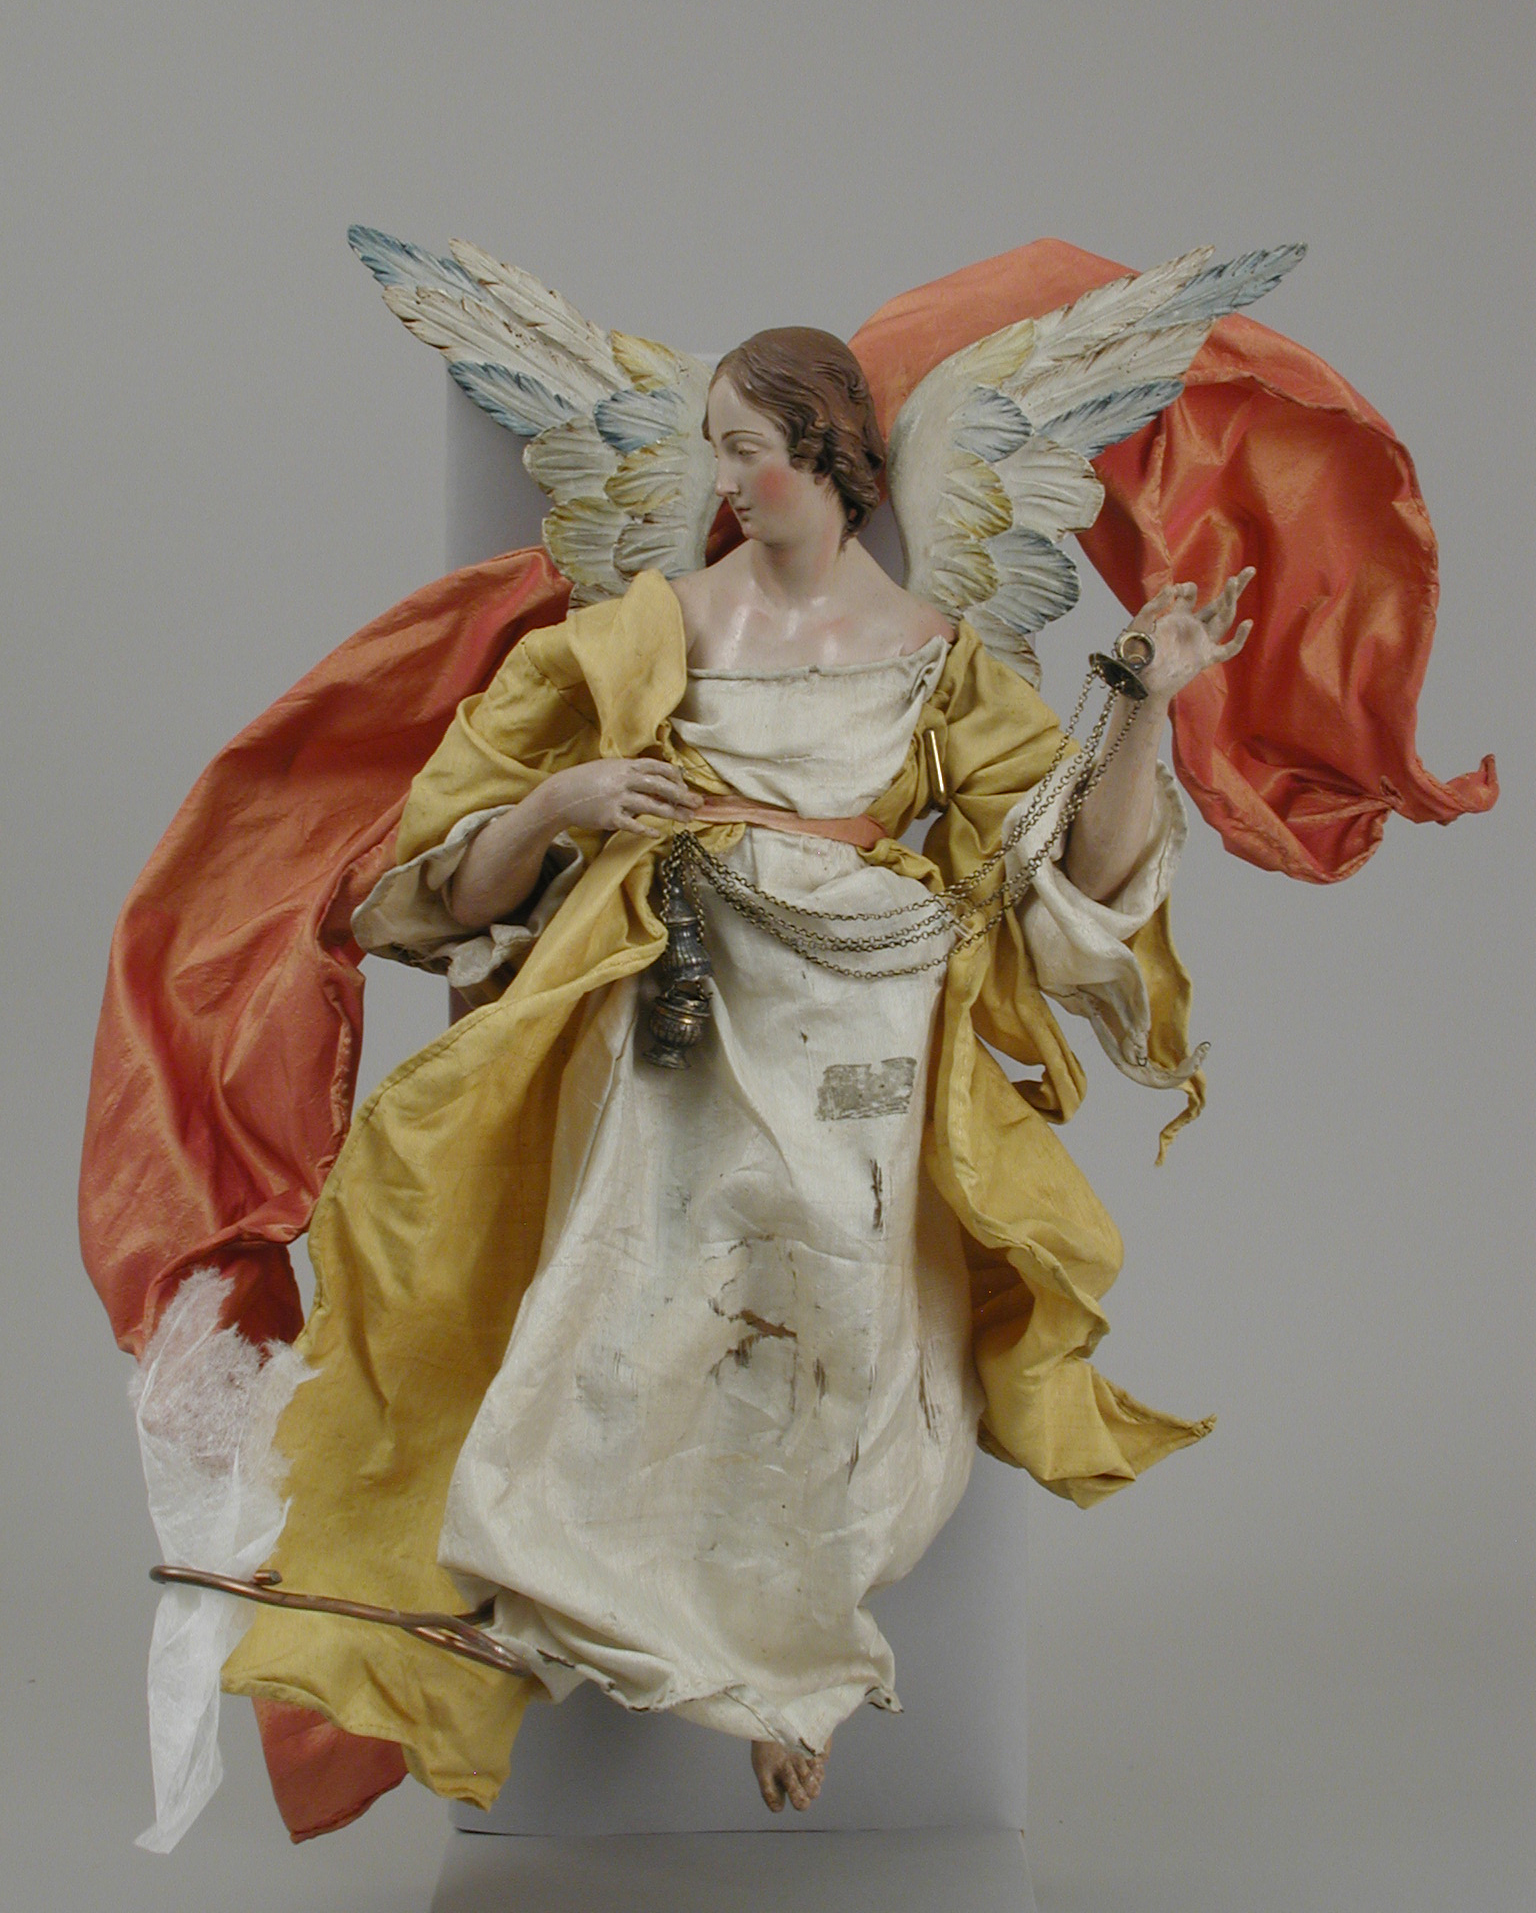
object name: crèche figure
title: Angel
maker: salvatore di franco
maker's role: maker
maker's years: 1700-1799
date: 1751-1800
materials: terracotta, fiber, metal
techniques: polychrome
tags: angels